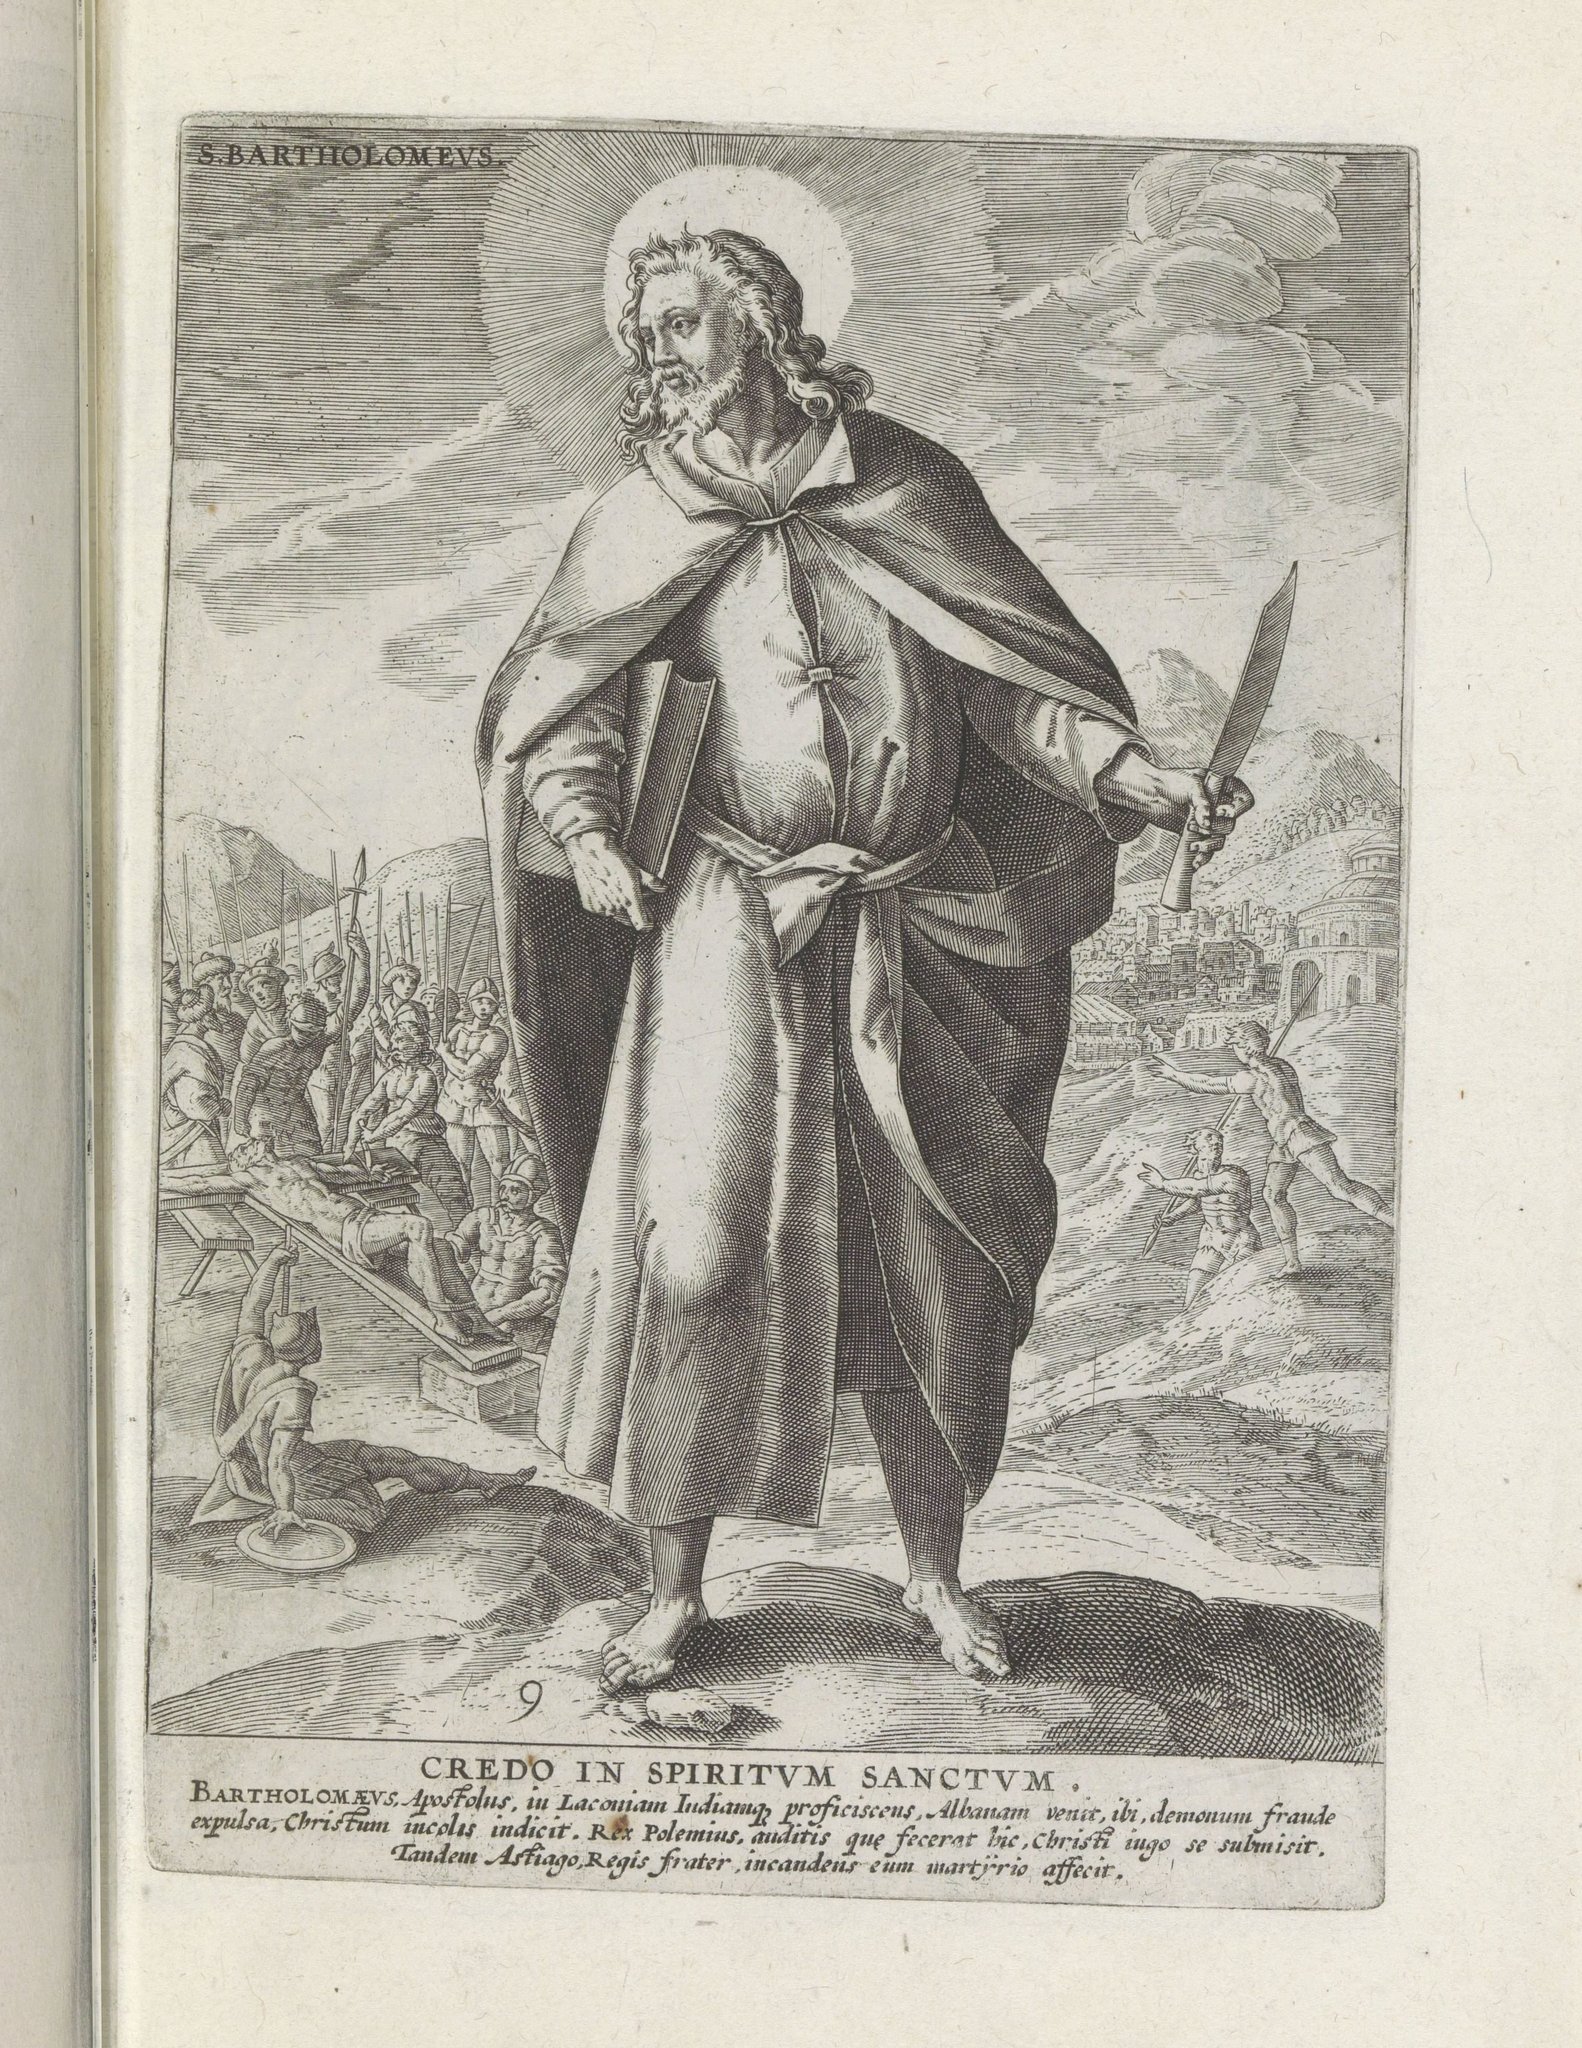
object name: album leaf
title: Bartolomeüs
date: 1585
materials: paper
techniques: engraving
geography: antwerp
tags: the apostle bartholomew; possible attributes: book, devil or dragon at feet, knife, scroll, flayed skin, staff, the apostle bartholomew; possible attributes: book, devil or dragon at feet, knife, scroll, flayed skin, staff - martyrdom, suffering, misfortune, death of male saint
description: De apostel Bartolomeüs staande met een boek in de ene hand en een mes in de andere hand. Links op de achtergrond zijn marteldood. Hij wordt levend gevild. Onder de voorstelling een regel uit de apostolische geloofsbelijdenis en een drieregelige tekst over Bartolomeüs in het Latijn. Deze prent maakt deel uit van een album.